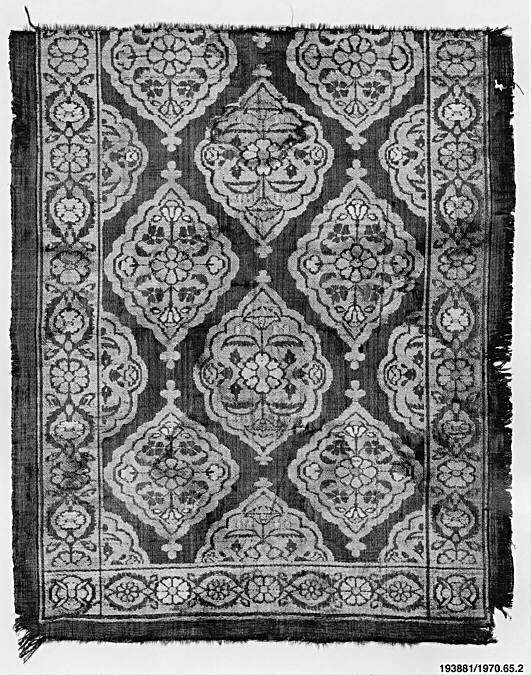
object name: textile fragment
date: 1601-1700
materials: silk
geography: turkey